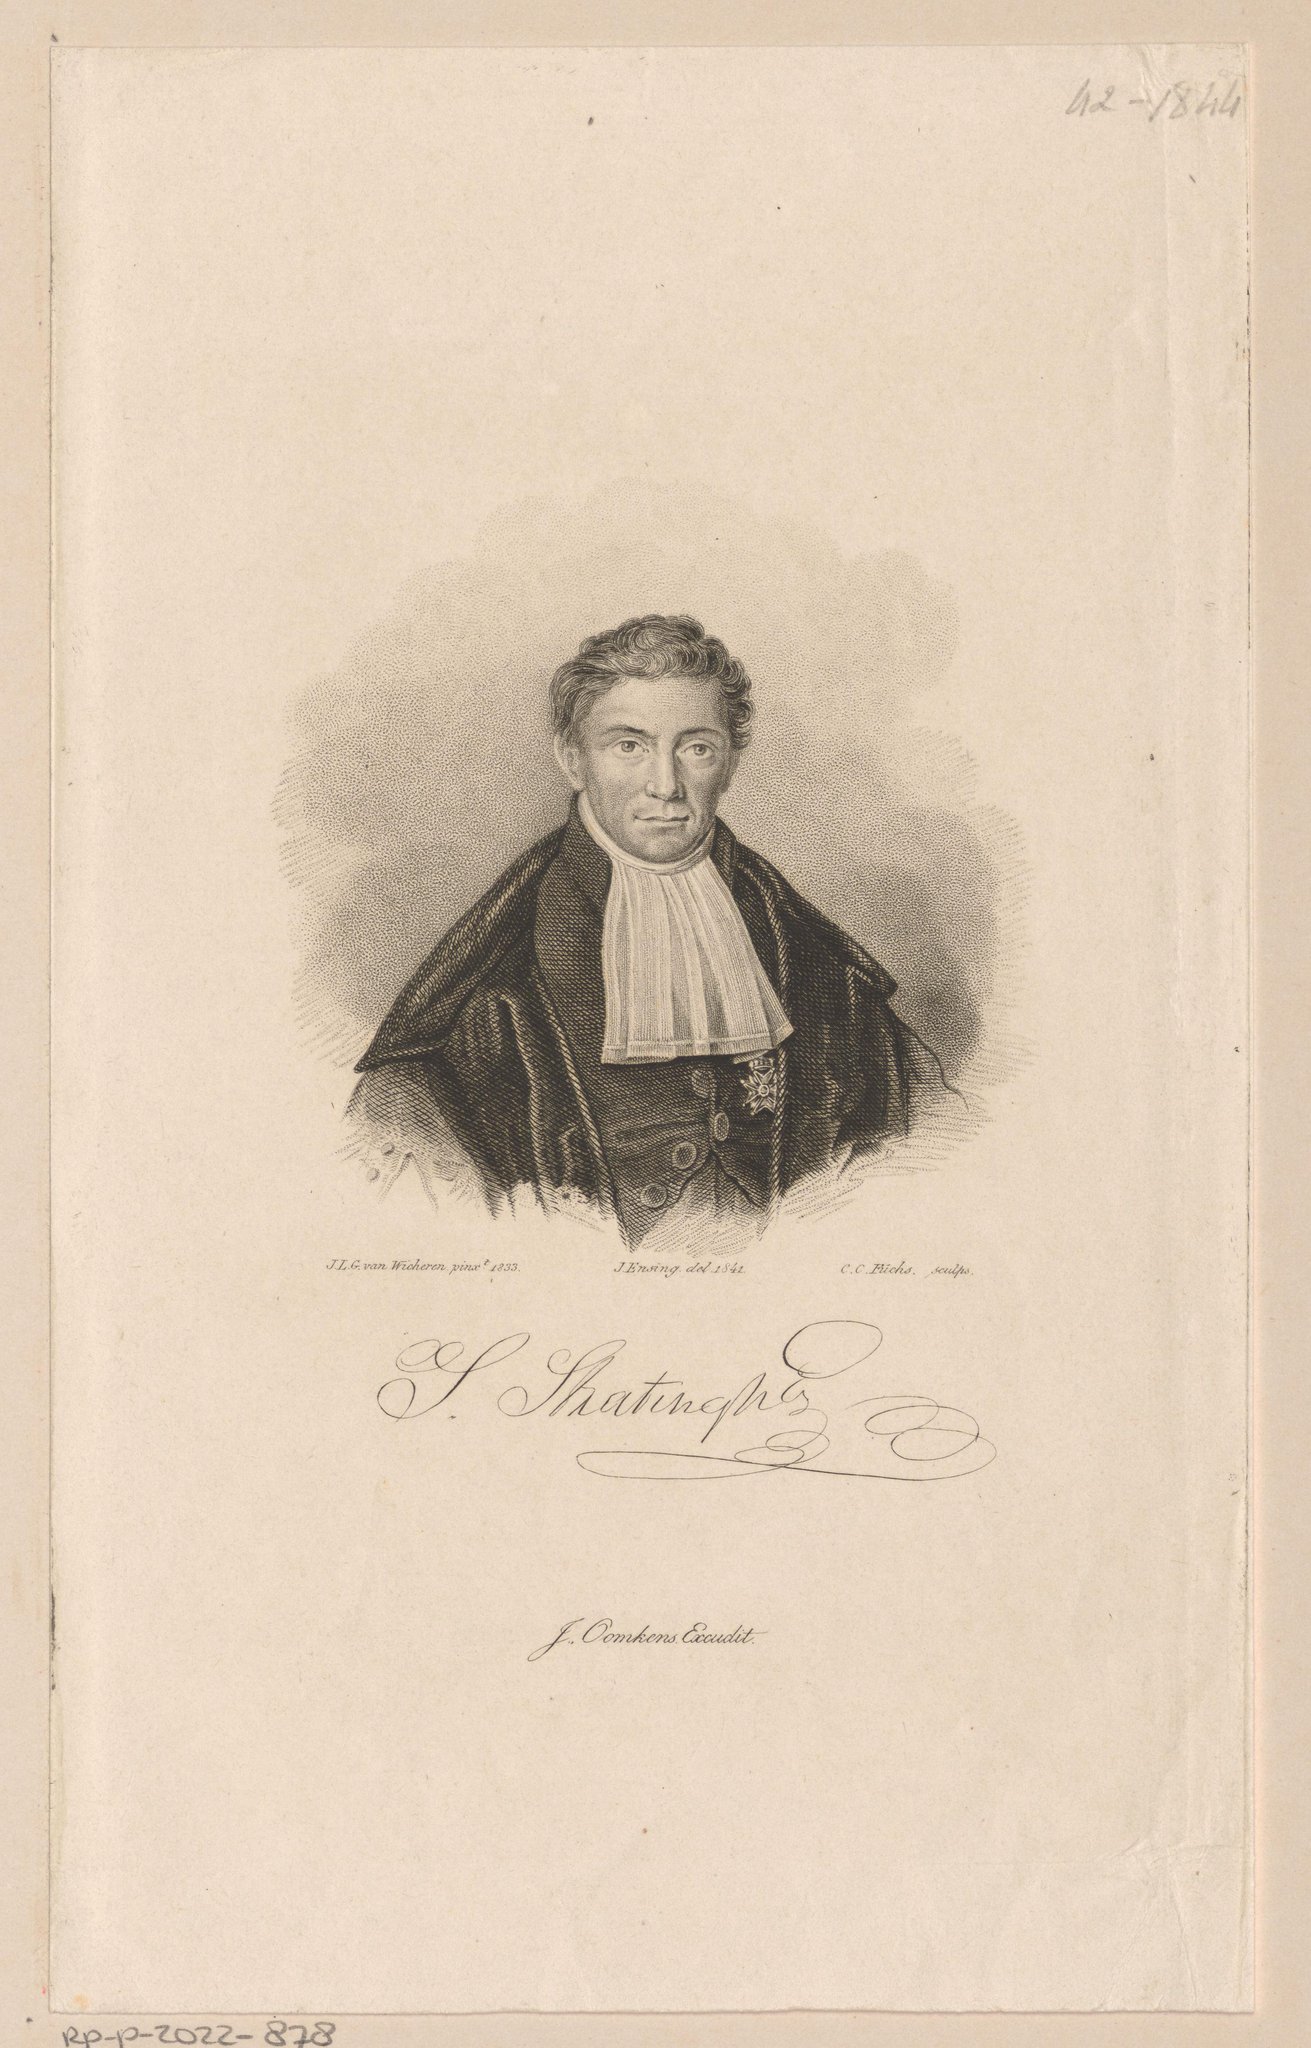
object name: print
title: Portret van Sibrandus Stratingh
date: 1841-1844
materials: paper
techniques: engraving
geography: groningen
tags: chemistry (+ portrait of scholar, scientist), historical persons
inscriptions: collector's mark: Lugt 2233